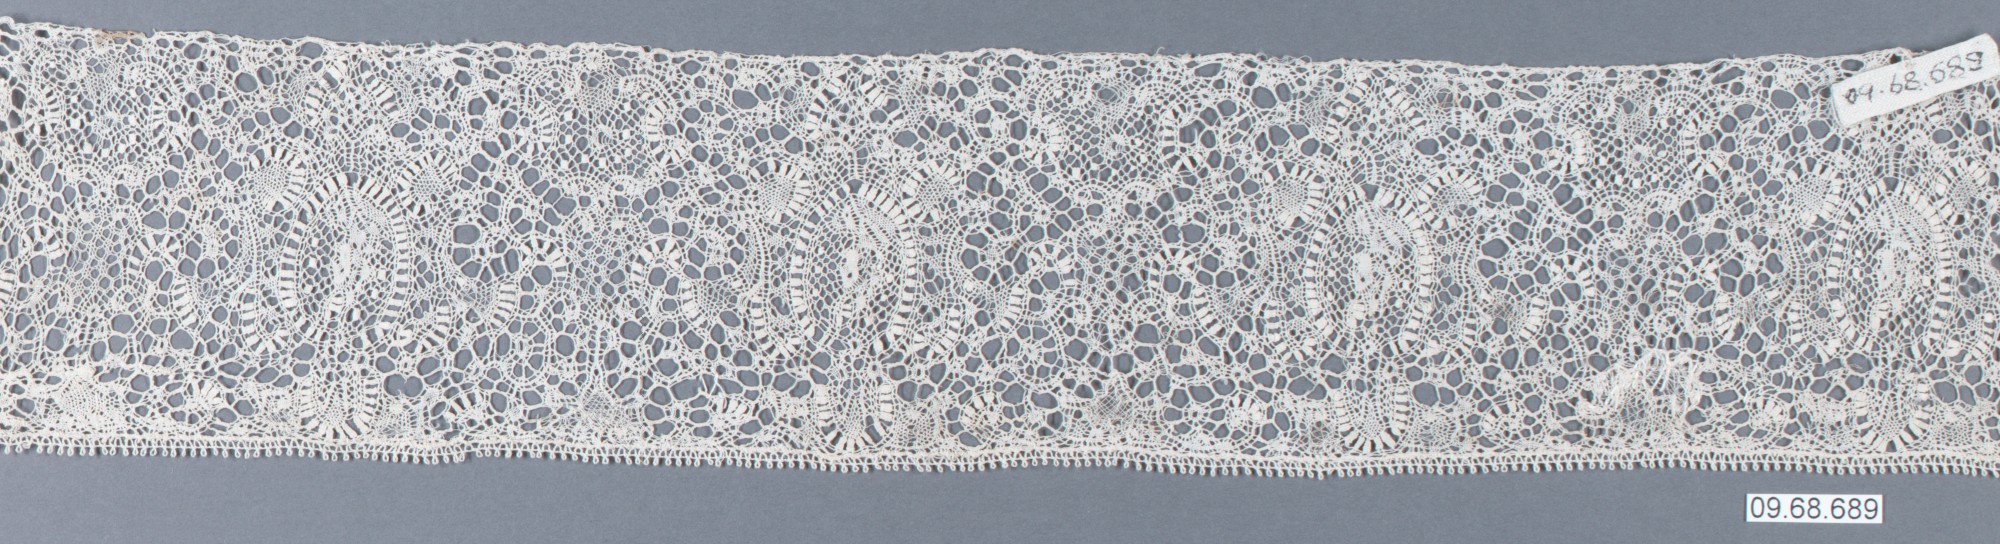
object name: piece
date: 1700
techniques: lace